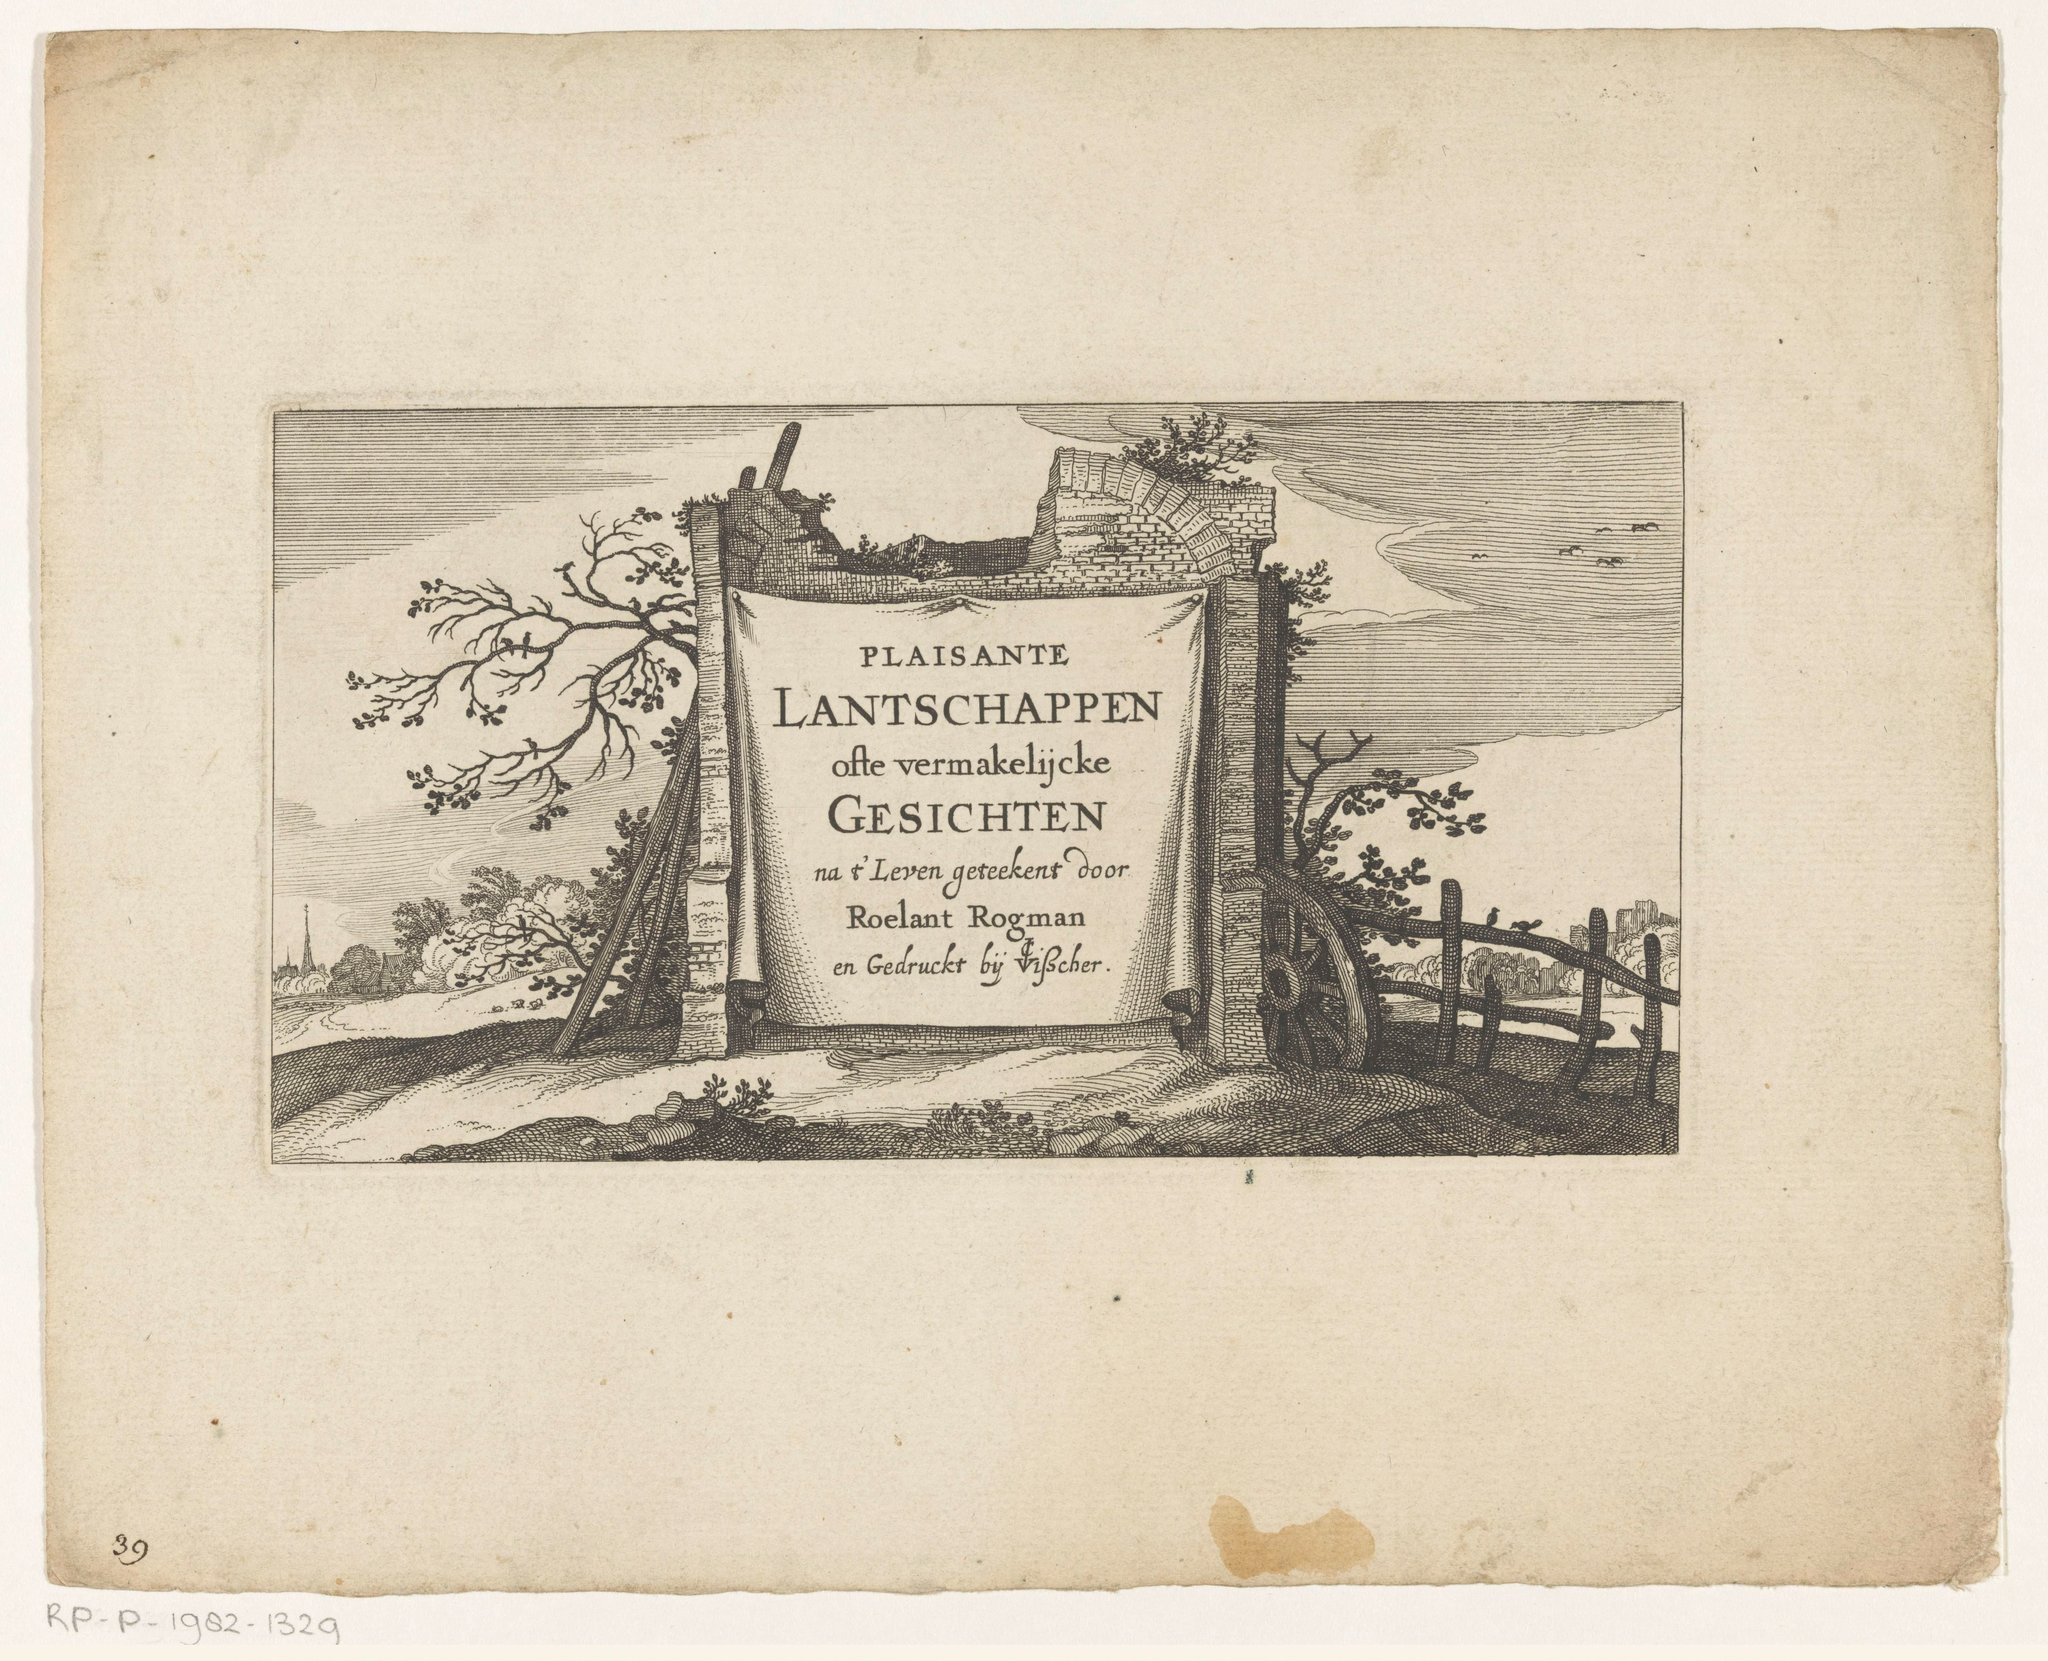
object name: titelprent, frontispice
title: Plaisante Lantschappen ofte vermakelijcke Gesichten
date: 1637-1652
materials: paper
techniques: etching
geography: amsterdam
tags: landscape with ruins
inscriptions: collector's mark: Lugt 2760, collector's mark: Lugt 2228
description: Een landschap met een ruïne waarop een doek met de serietitel.